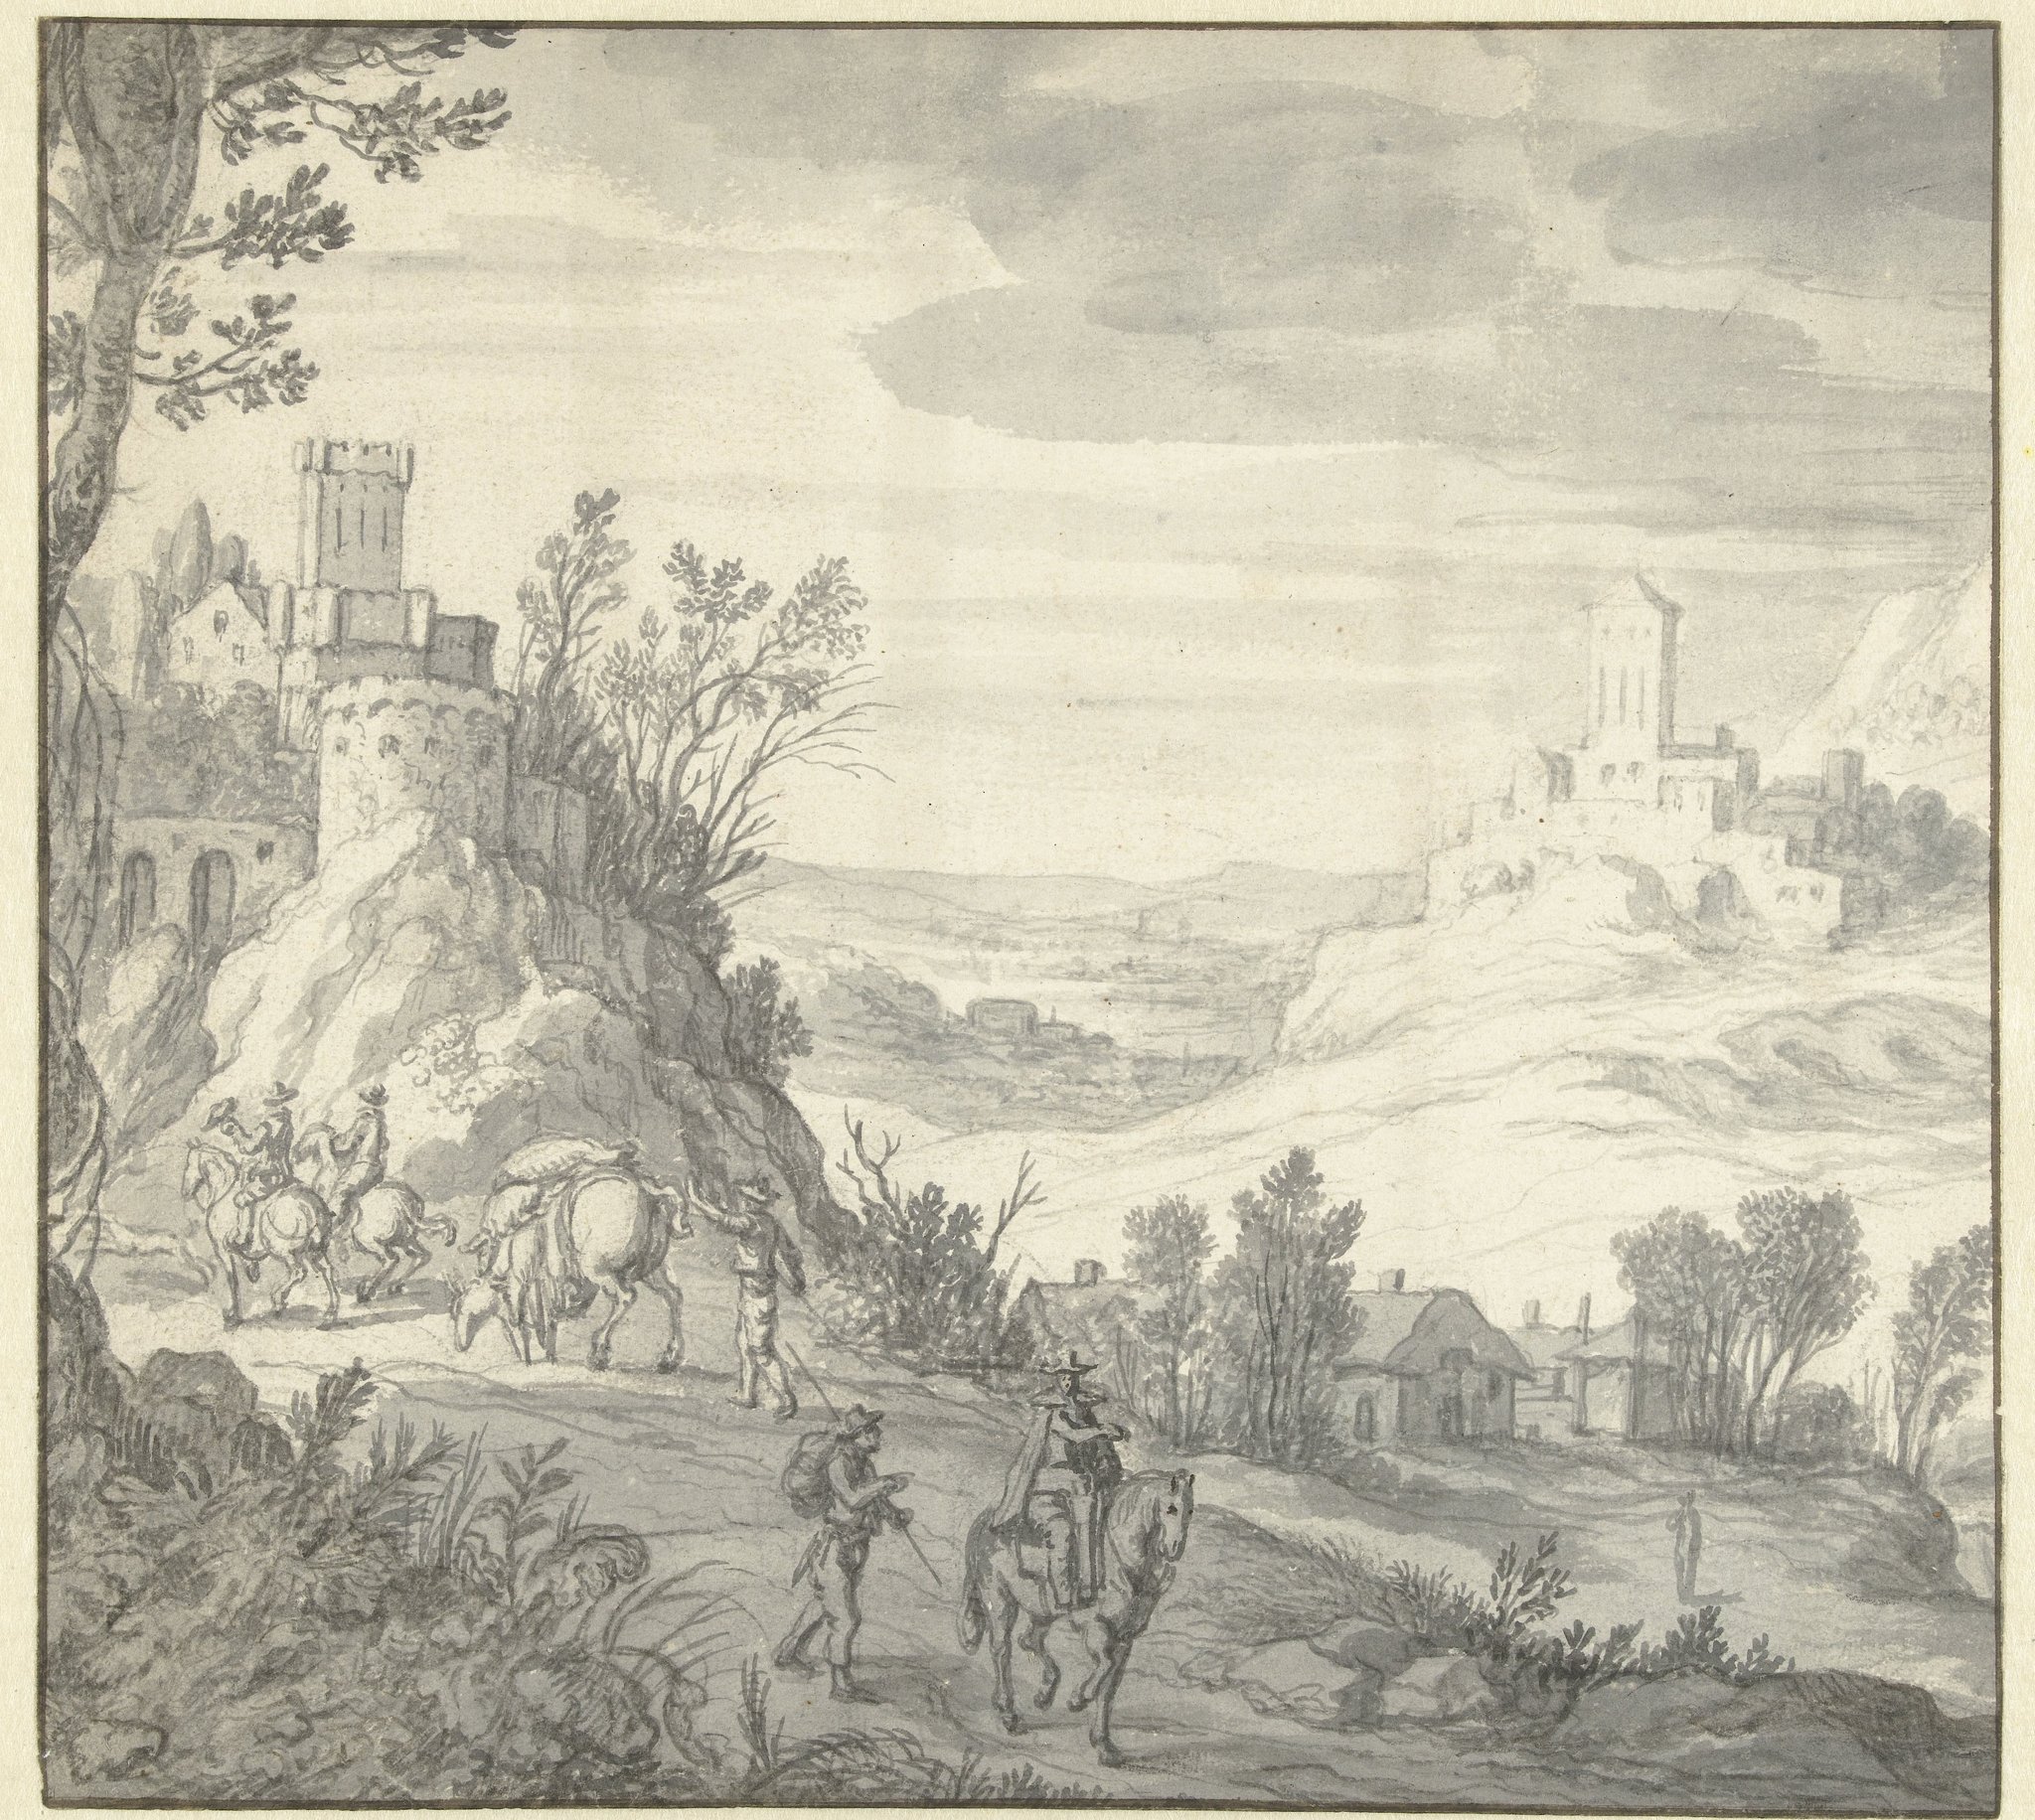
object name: drawing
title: Berglandschap met een kasteel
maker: adriaen van nieulandt (i)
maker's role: draughtsman, painter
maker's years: 1586-1658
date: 1597-1658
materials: paper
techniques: brush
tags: riding a horse, ass, or mule; rider, horseman, castle, stadia of travel, mountains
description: Berglandschap met links een kasteel en op de voorgrond reizigers.